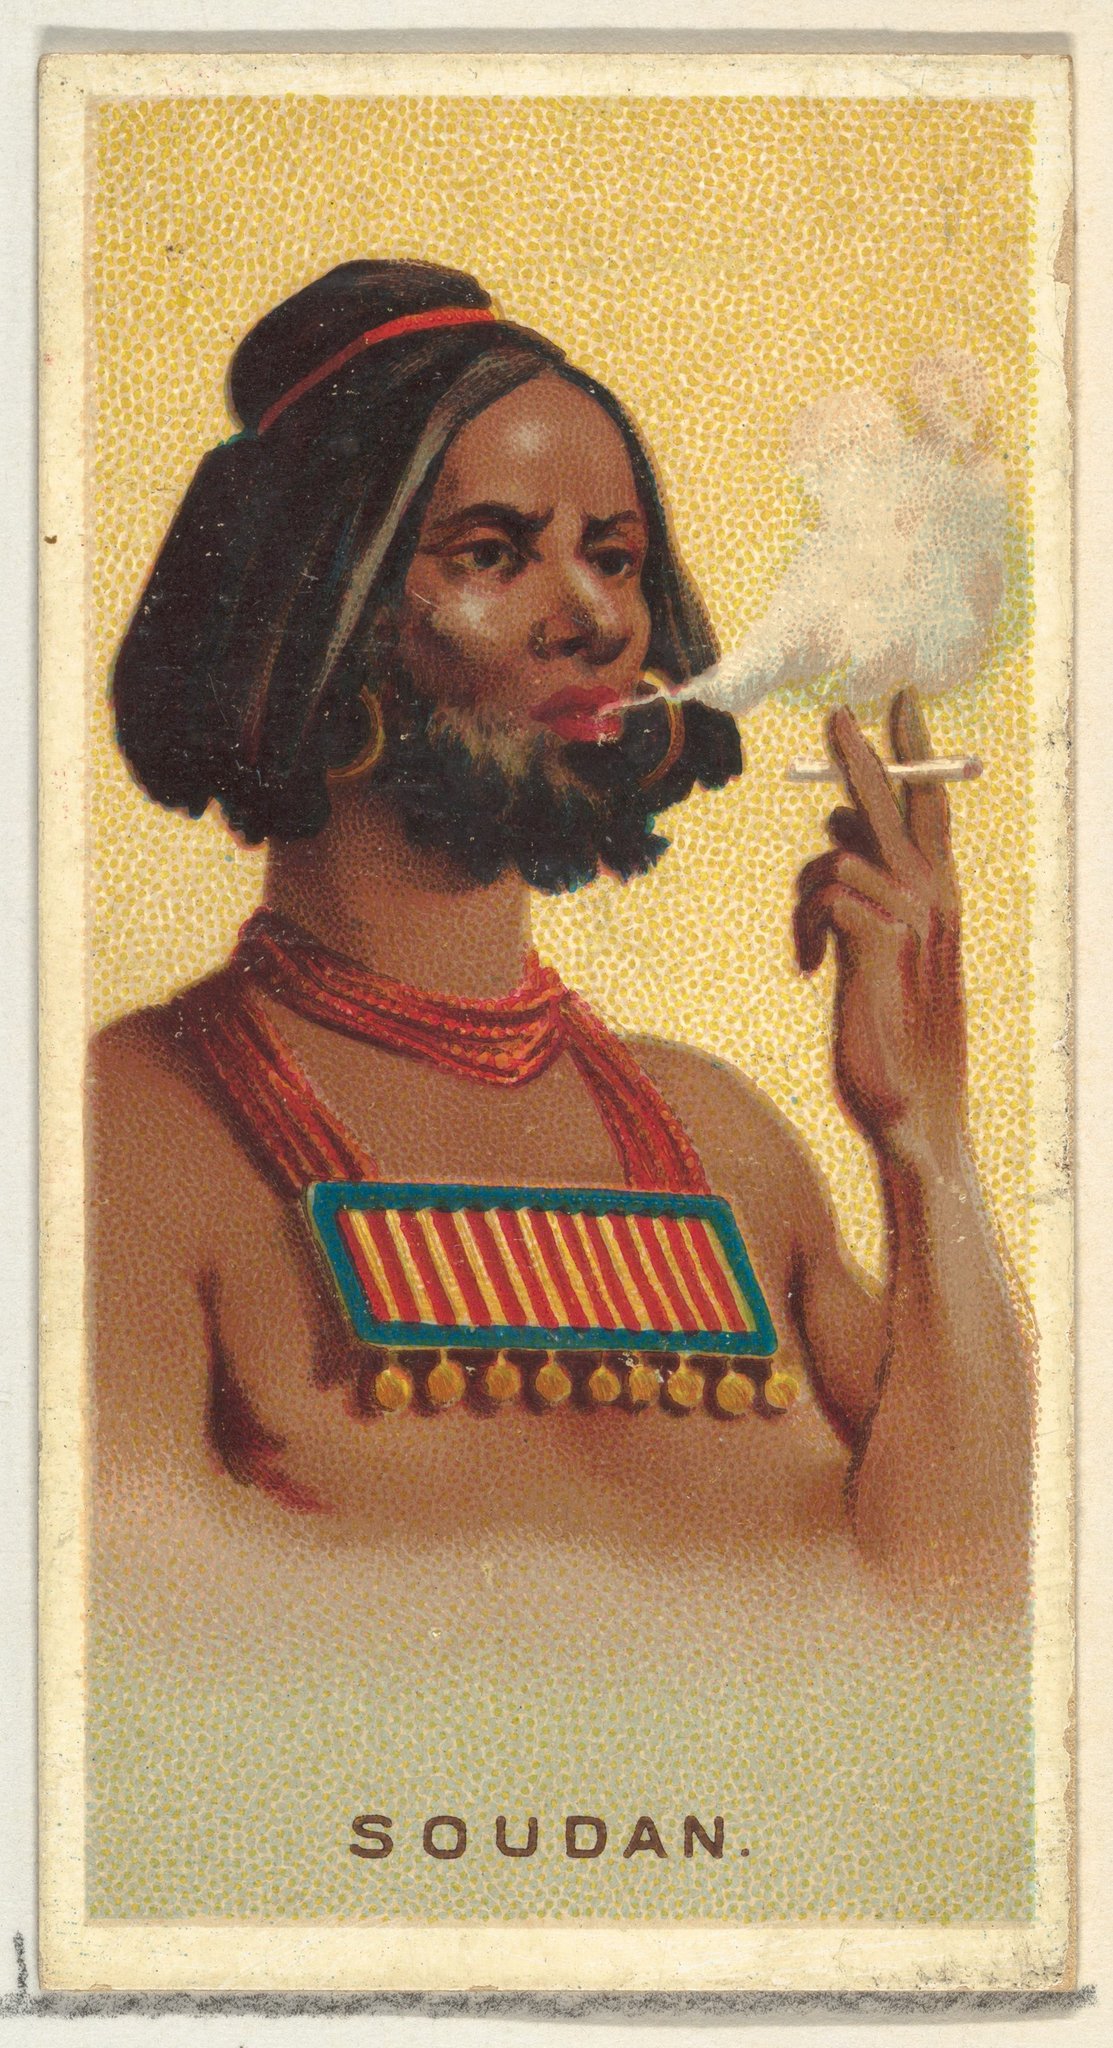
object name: print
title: Sudan, from World's Smokers series (N33) for Allen & Ginter Cigarettes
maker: allen & ginter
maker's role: publisher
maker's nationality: american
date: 1888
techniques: color lithograph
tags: men,smoking